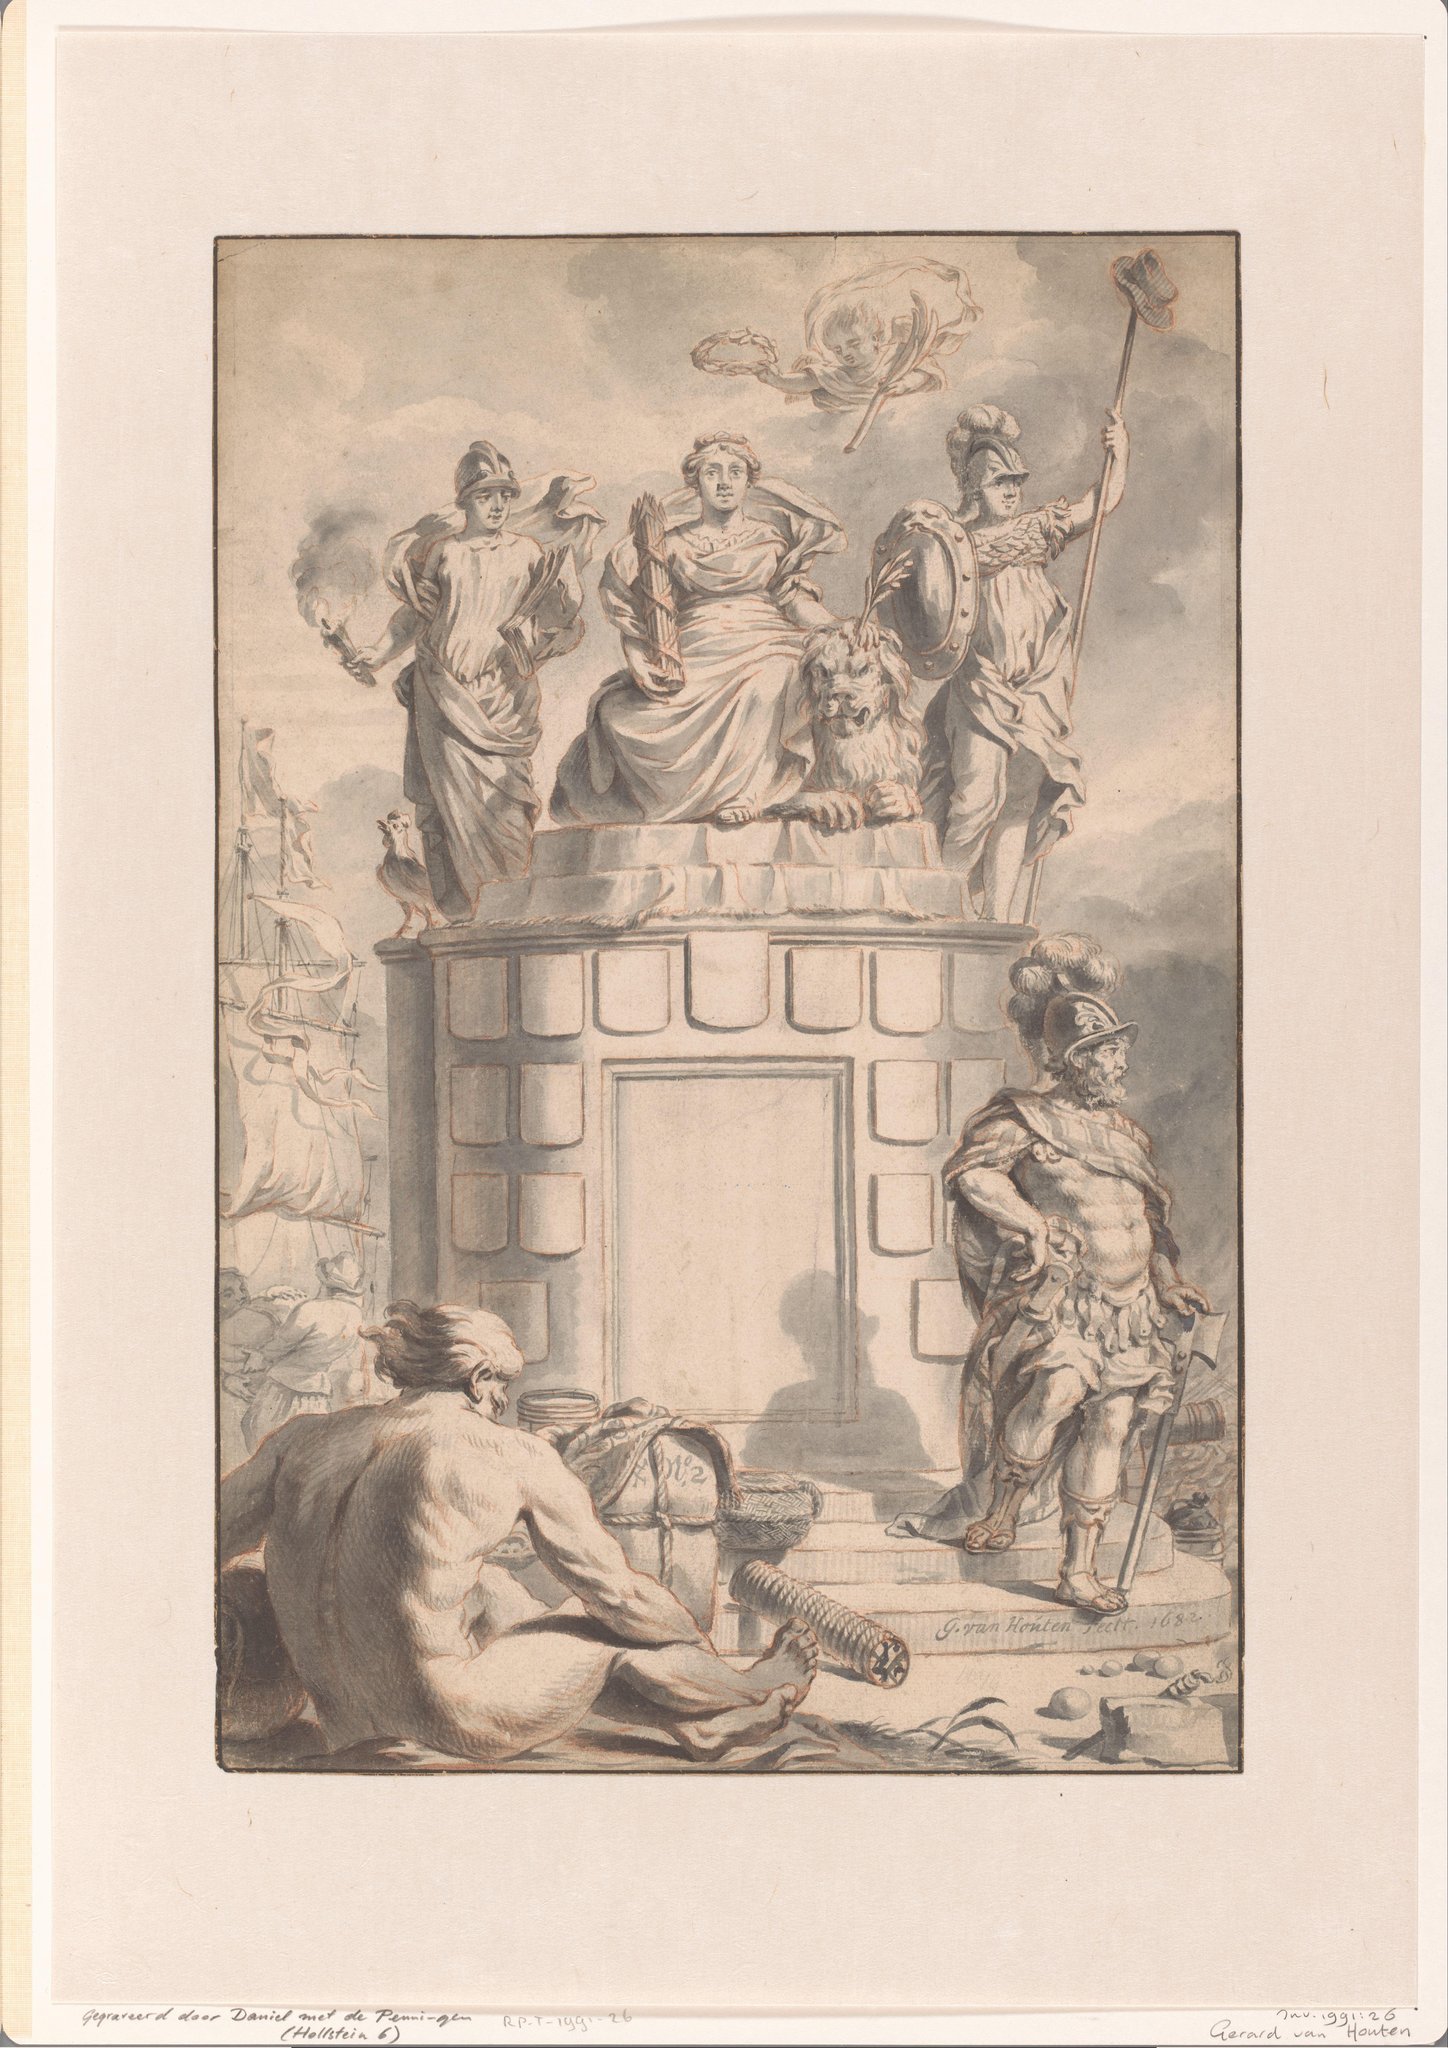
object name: design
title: Ontwerp voor een titelprent met de Nederlandsche maagd (?)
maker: gerard van houten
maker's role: print maker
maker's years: -1706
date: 1682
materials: chalk, ink, paper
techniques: brush, pen